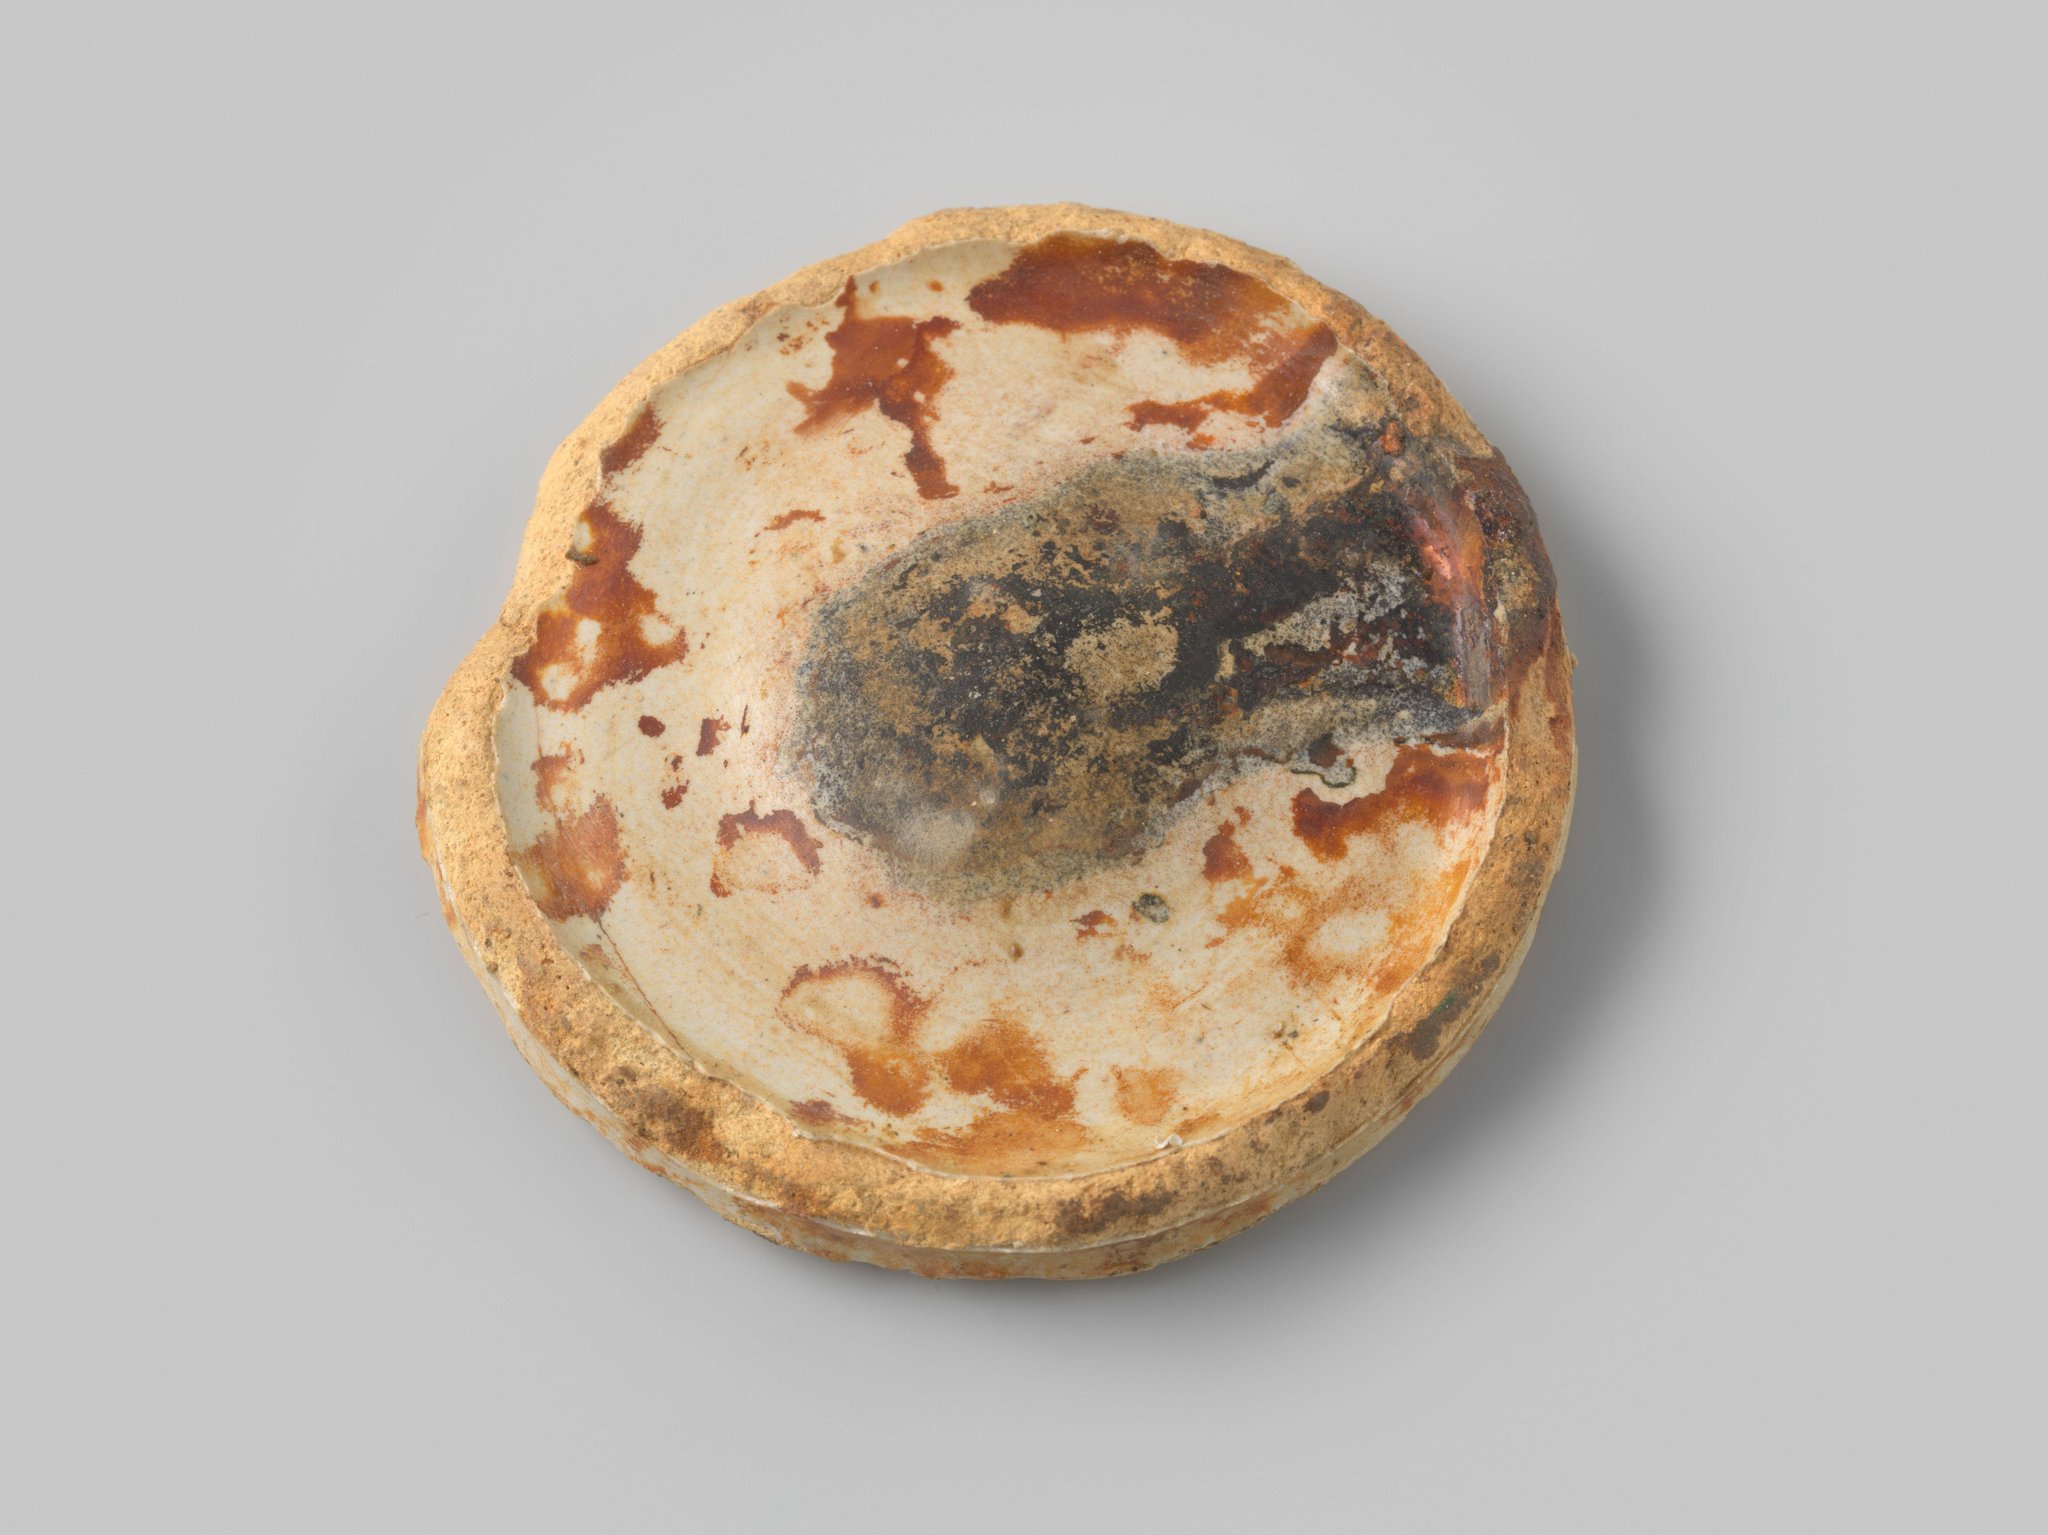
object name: sherd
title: Bodemfragment van een apothekerspot uit het wrak van de Oost-Indiëvaarder Hollandia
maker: Anonymous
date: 1700-1743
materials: faience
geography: netherlands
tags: verenigde oostindische compagnie, hollandia (schip), annet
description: Faience (tin-glazed), apothecaries'jars; fragm, base, eroded, circular, centre slightly convex, glazed interior.